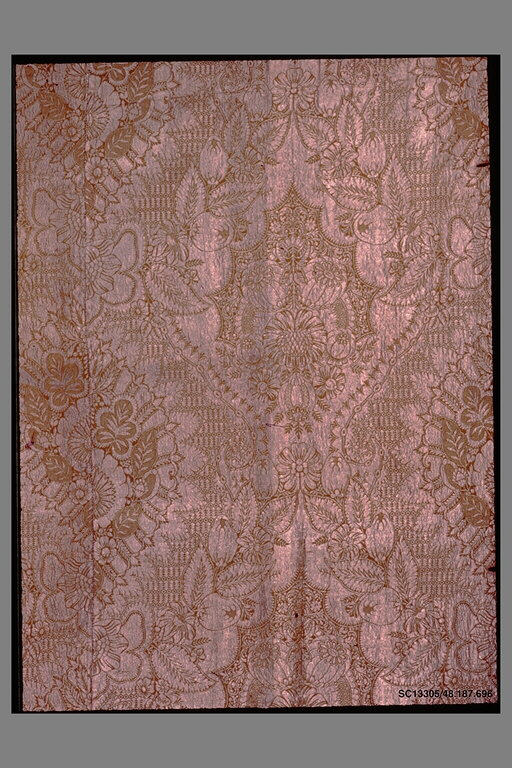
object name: piece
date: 1705-1710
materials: metal thread, silk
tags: flowers,leaves